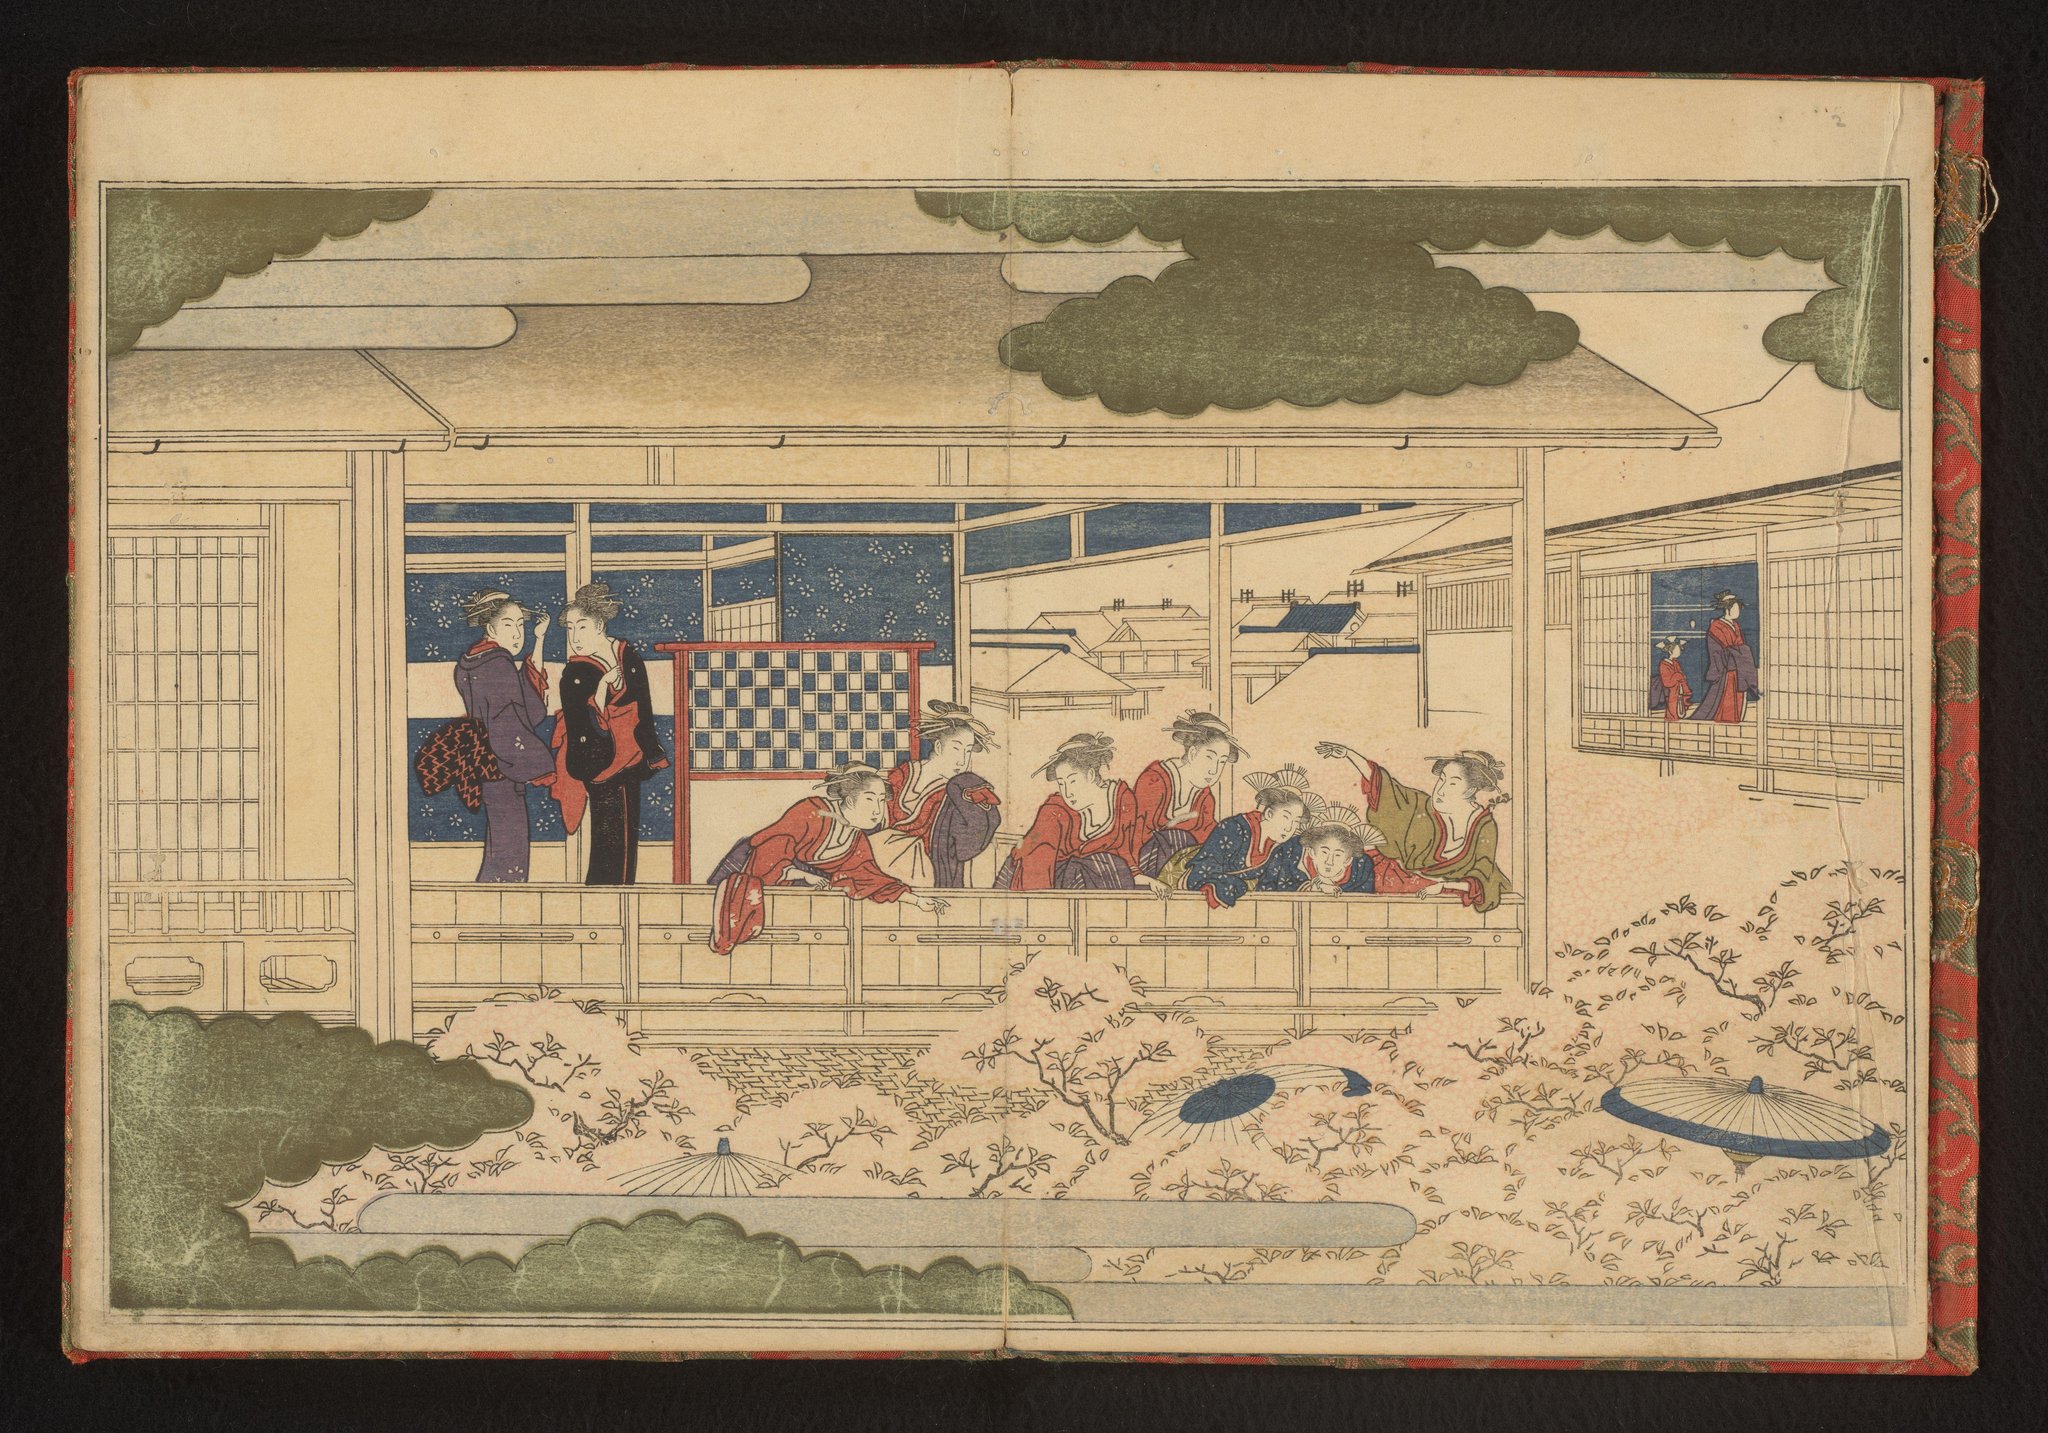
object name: page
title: Viewing the parade down the main street, Nakanochô, in the Yoshiwara pleasure quarter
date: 1790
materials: gold powder, paper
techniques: woodcut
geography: edo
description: Derde en vierde pagina uit het boek Fugenzo van Utamaro.